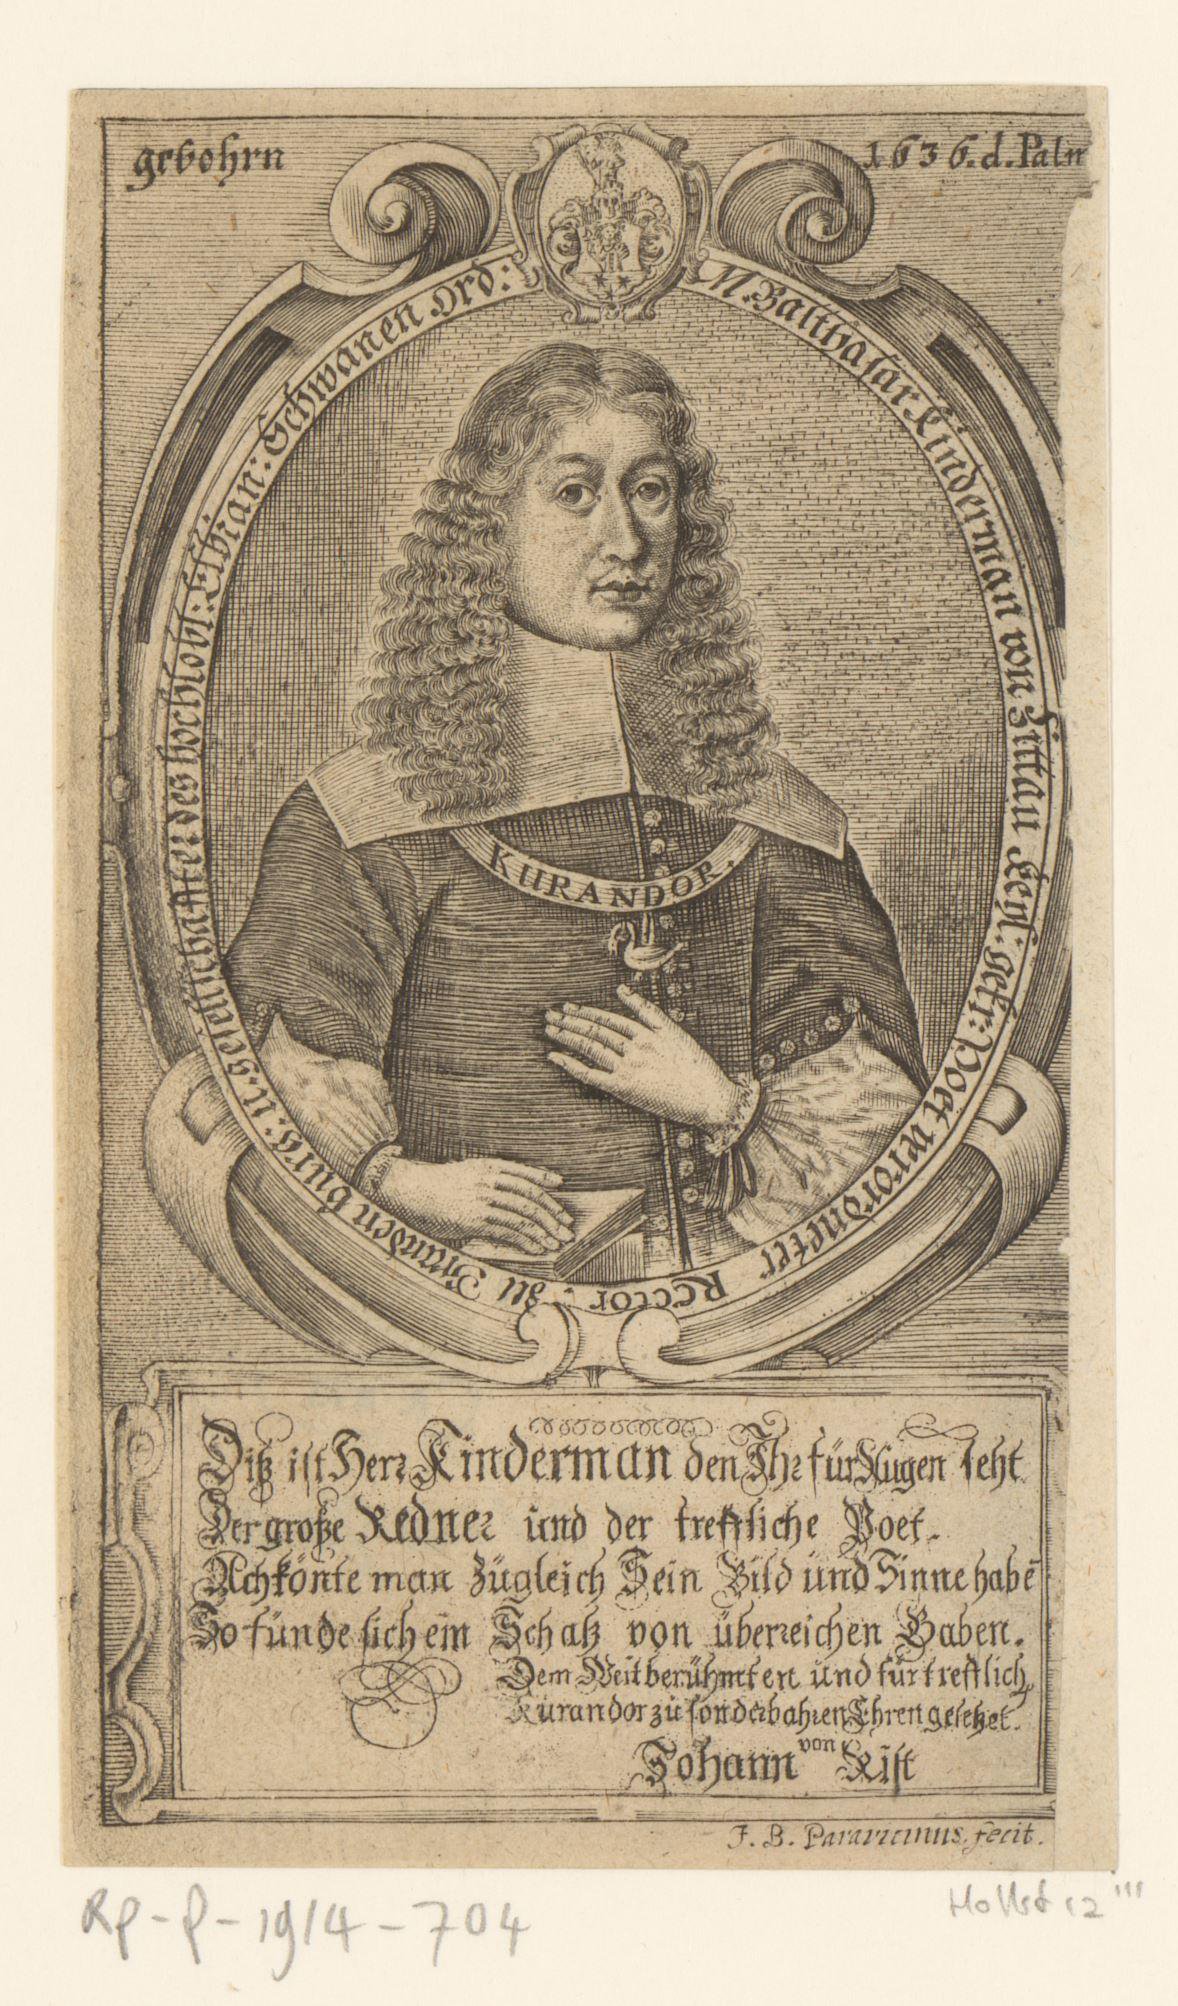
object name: print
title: Portret van Balthasar Kindermann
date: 1656-1676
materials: paper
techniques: engraving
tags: historical persons, book, armorial bearing, heraldry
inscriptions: collector's mark: Lugt 2228